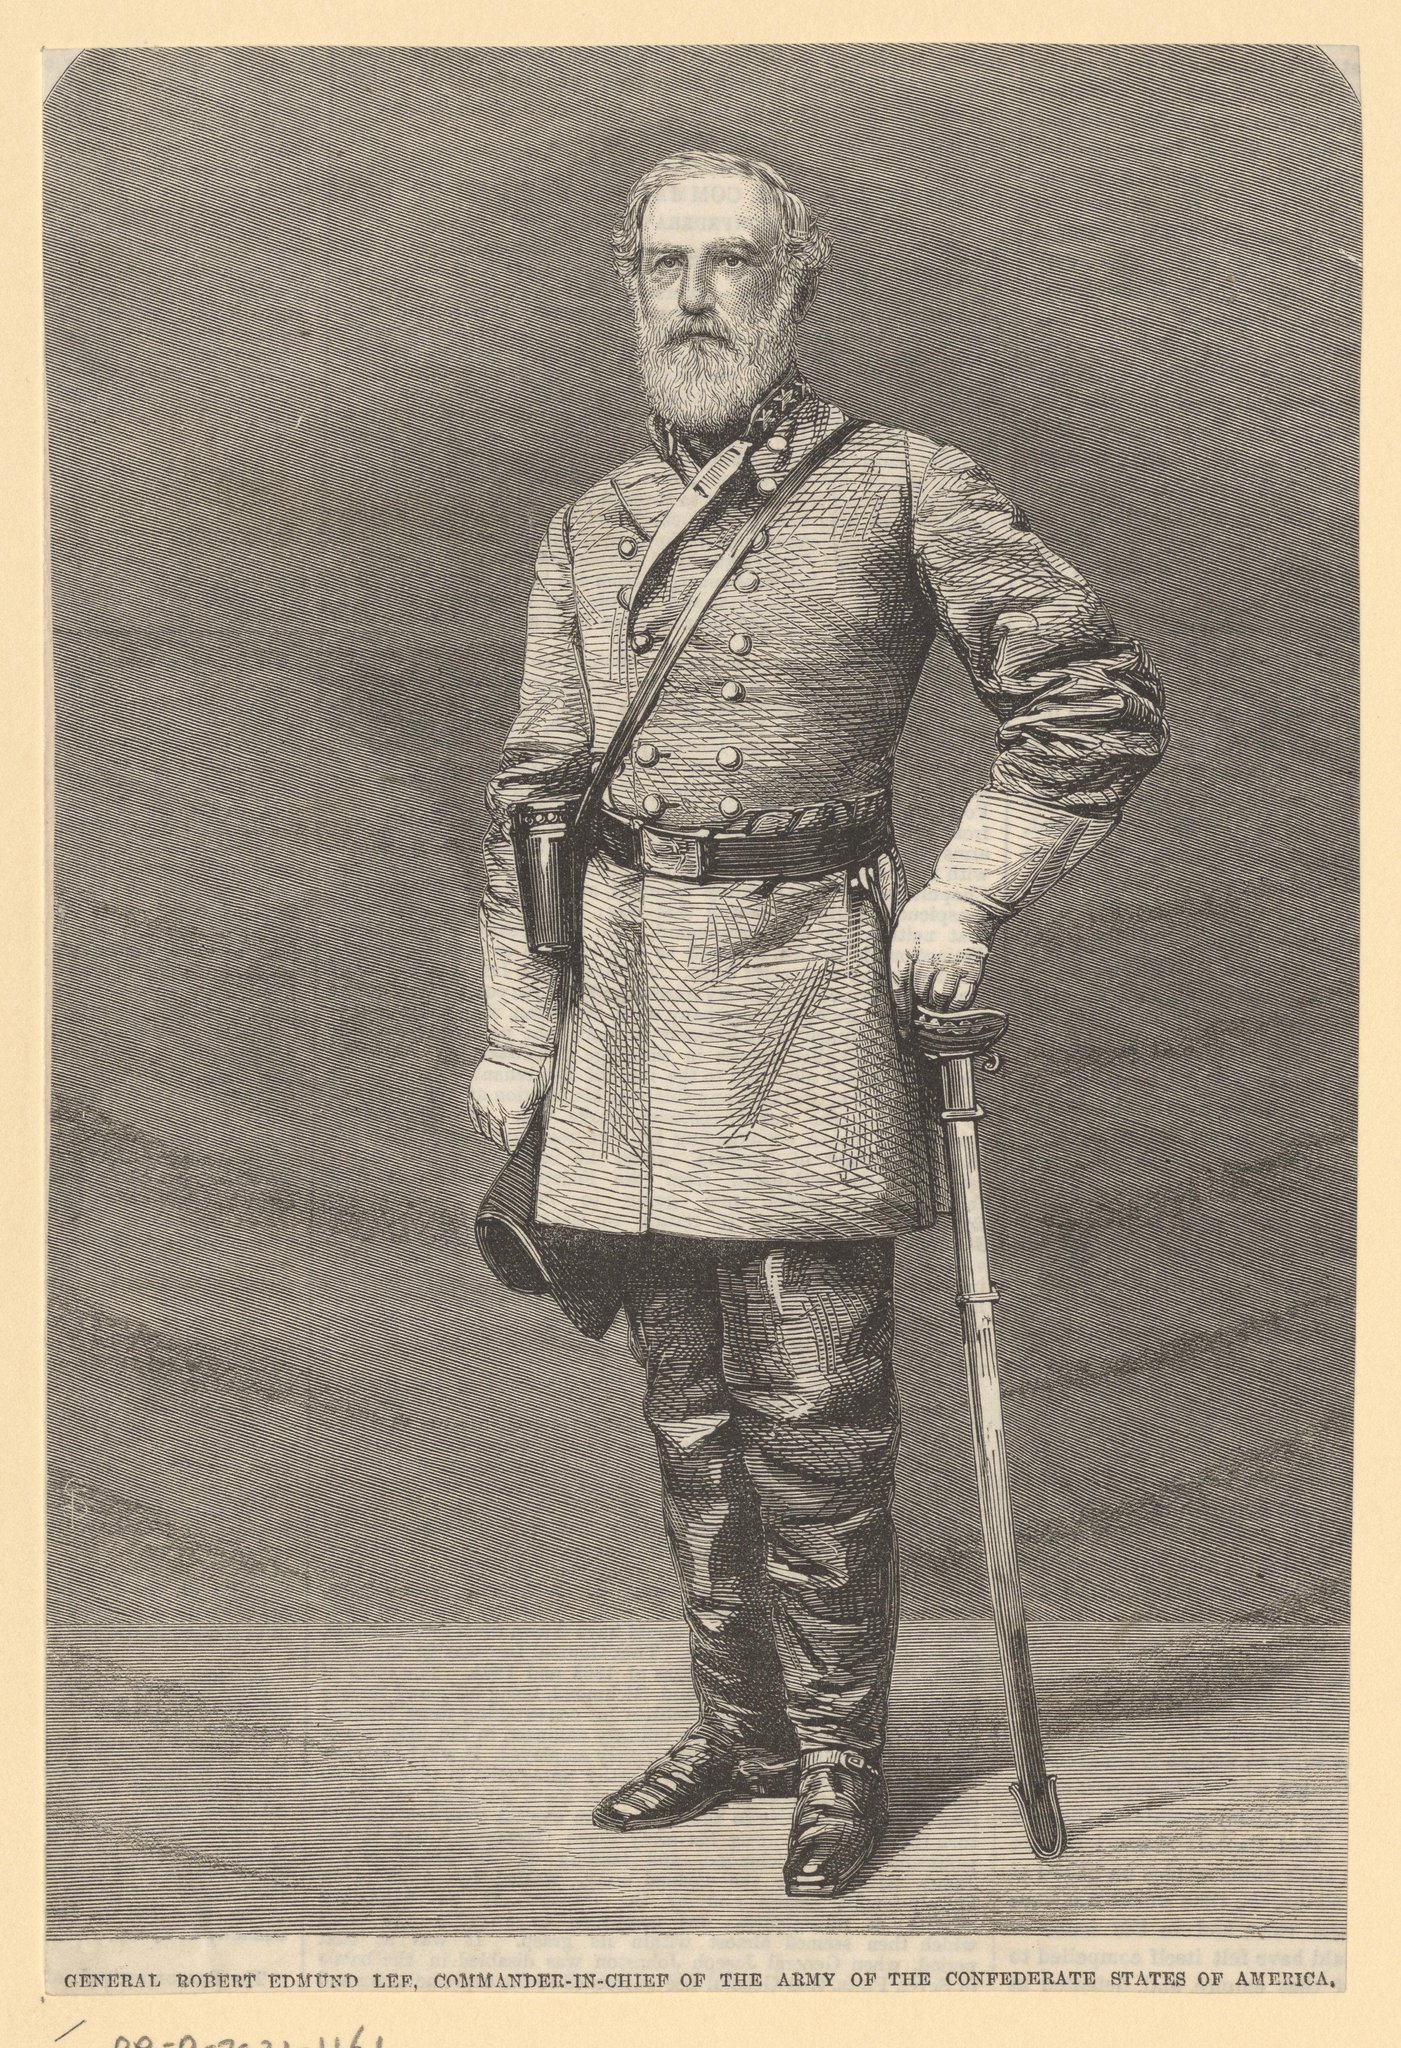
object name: print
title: Portret van Robert Edward Lee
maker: Anonymous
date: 1864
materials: paper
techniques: letterpress printing, engraving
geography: london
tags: commander-in-chief, general, marshal, historical persons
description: Prent uit: The Illustrated London News (1864), nr. 1262, 4 juni 1864.